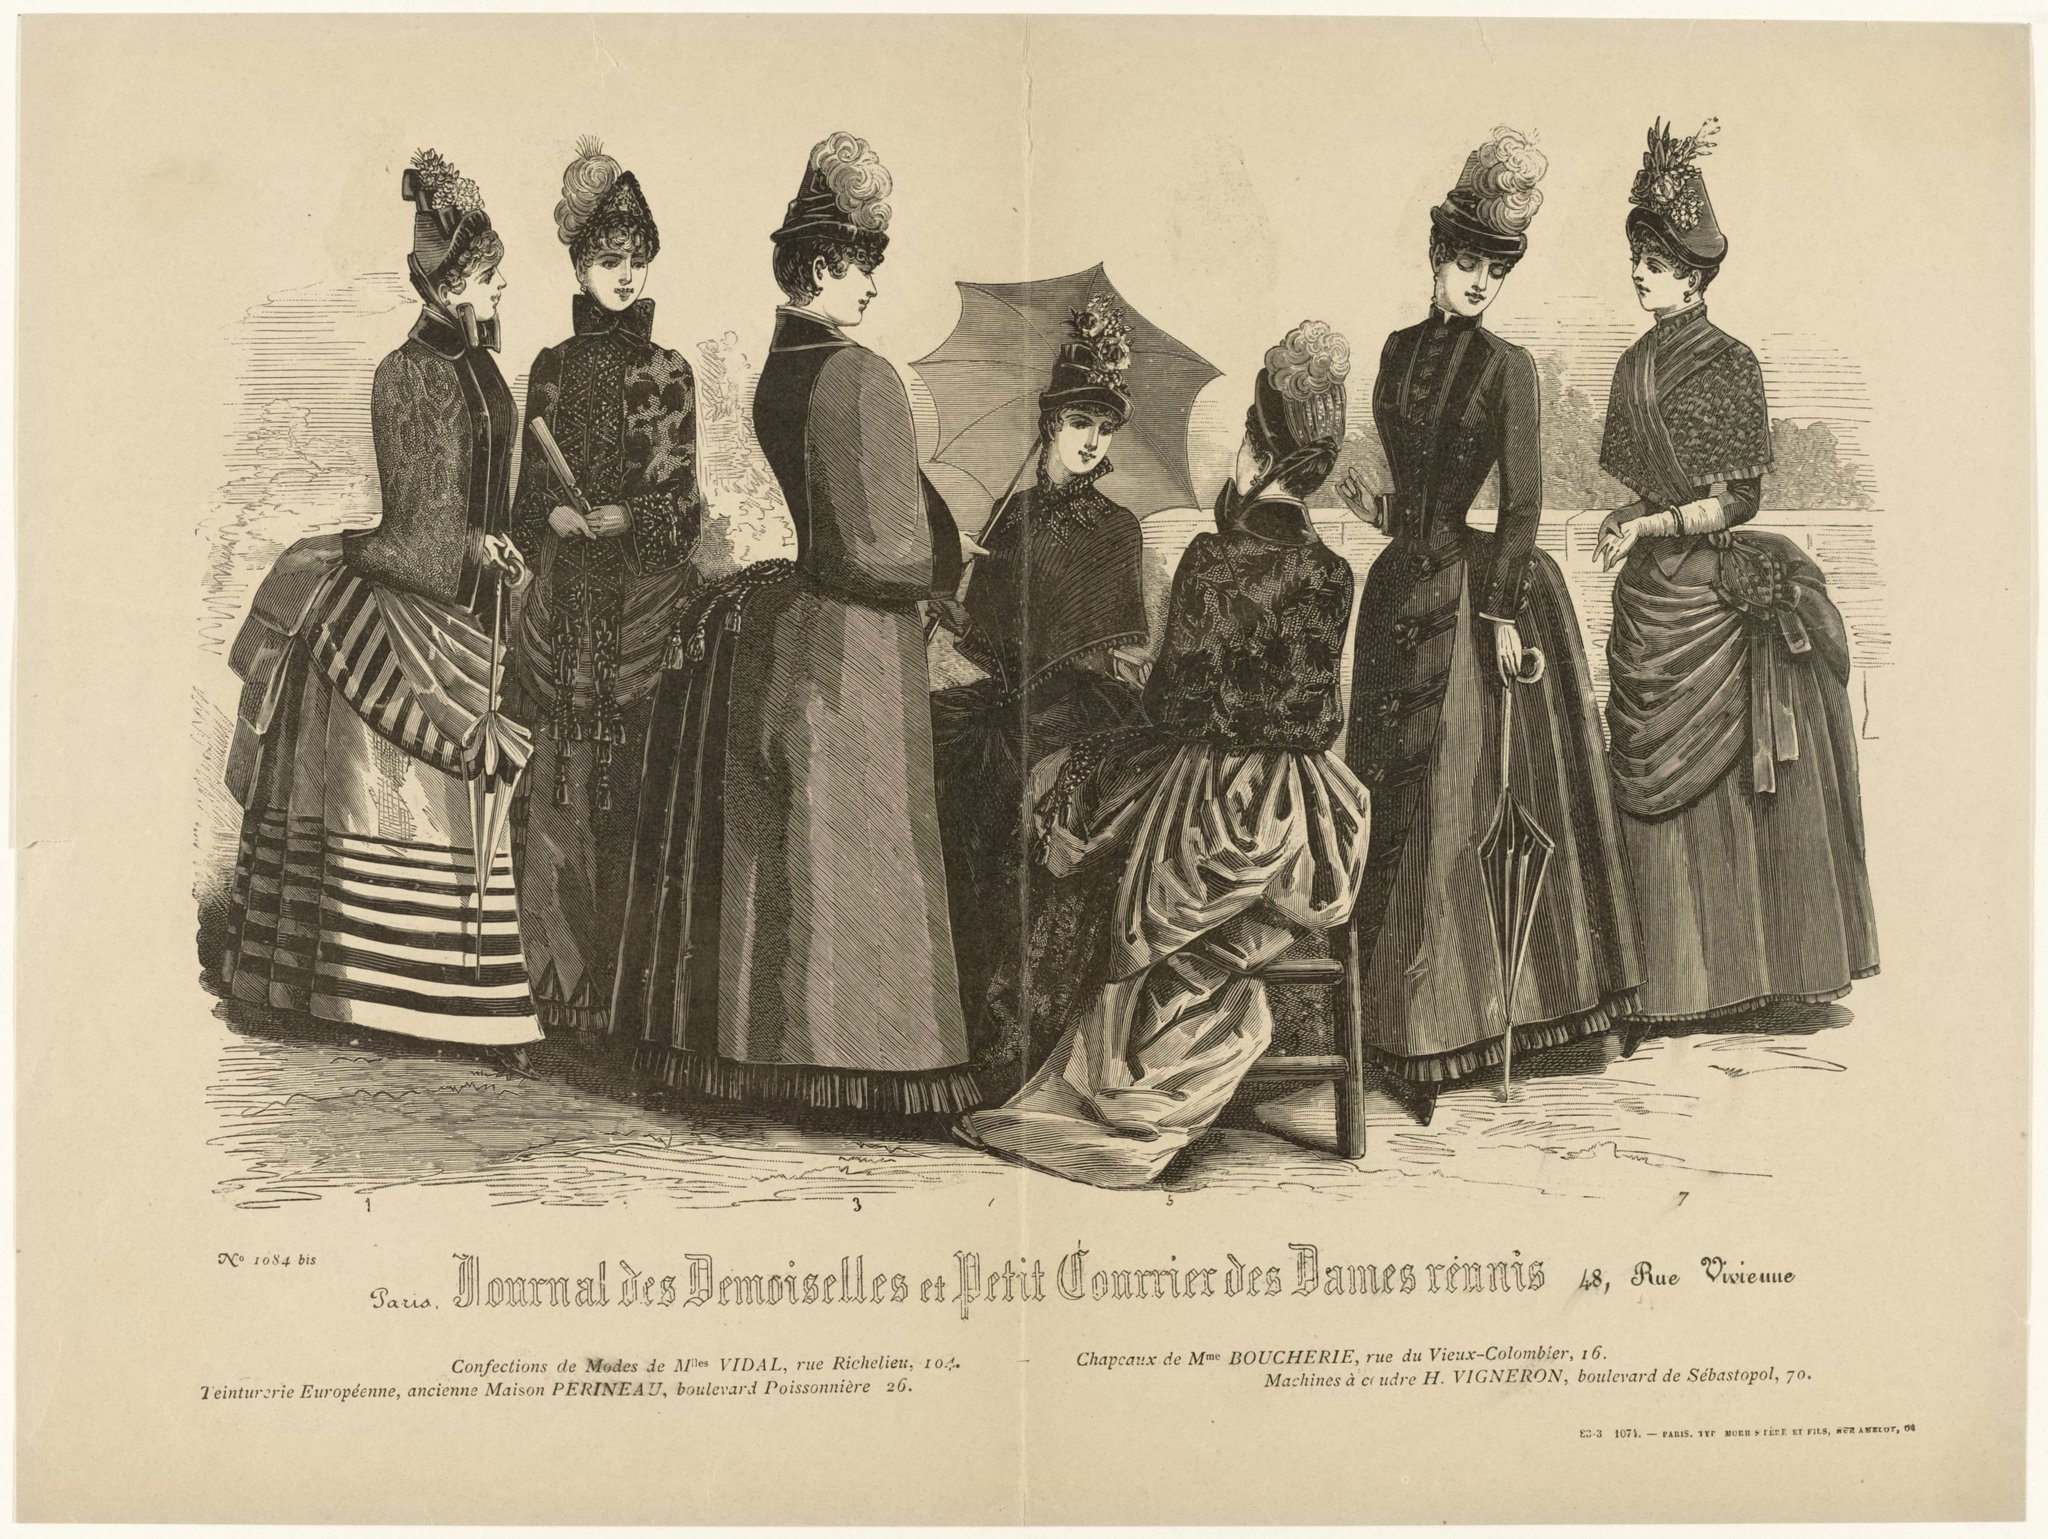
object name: fashion print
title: Journal des Demoiselles et Petit Courrier des Dames Réunis, ca. 1885, No. 1084 bis: Confections de Modes (...)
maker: Anonymous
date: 1885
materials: paper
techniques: engraving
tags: walking-stick, staff, cane (+ women's clothes), dress, gown: walking dress (+ women's clothes), clothing for the upper part of the body (mantelet) (+ women's clothes), fashion plates, head-gear: hat (+ women's clothes)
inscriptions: title: ‘Journal des Demoiselles et Petit Courrier des Dames Réunis’, caption: ‘Confections de Modes de Mlles VIDAL, rue Richelieu, 104 / Teinturerie Européenne, ancienne Maison PERINEAU, boulevard Poissonnière 26. / Chapeaux de Mme BOUCHERIE, rue du Vieux-Colombier, 16. / Machines à coudre H. VIGNERON, boulevard de Sébastopol, 70.’, address: ‘E3-3 1074 - PARIS, TYP MORR & PÉRE ET FILS, RUE AMELOT, 64’, address: ‘Paris. / 48, Rue Vivienne’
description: Zeven vrouwen in 'confections de Modes' van Mlles Vidal. Hoeden van Boucherie. Hieronder enkele regels reclametekst voor verschillende producten. Prent uit het modetijdschrift Journal des Demoiselles (et Petit Courrier des Dames Réunis) (1833-1922).